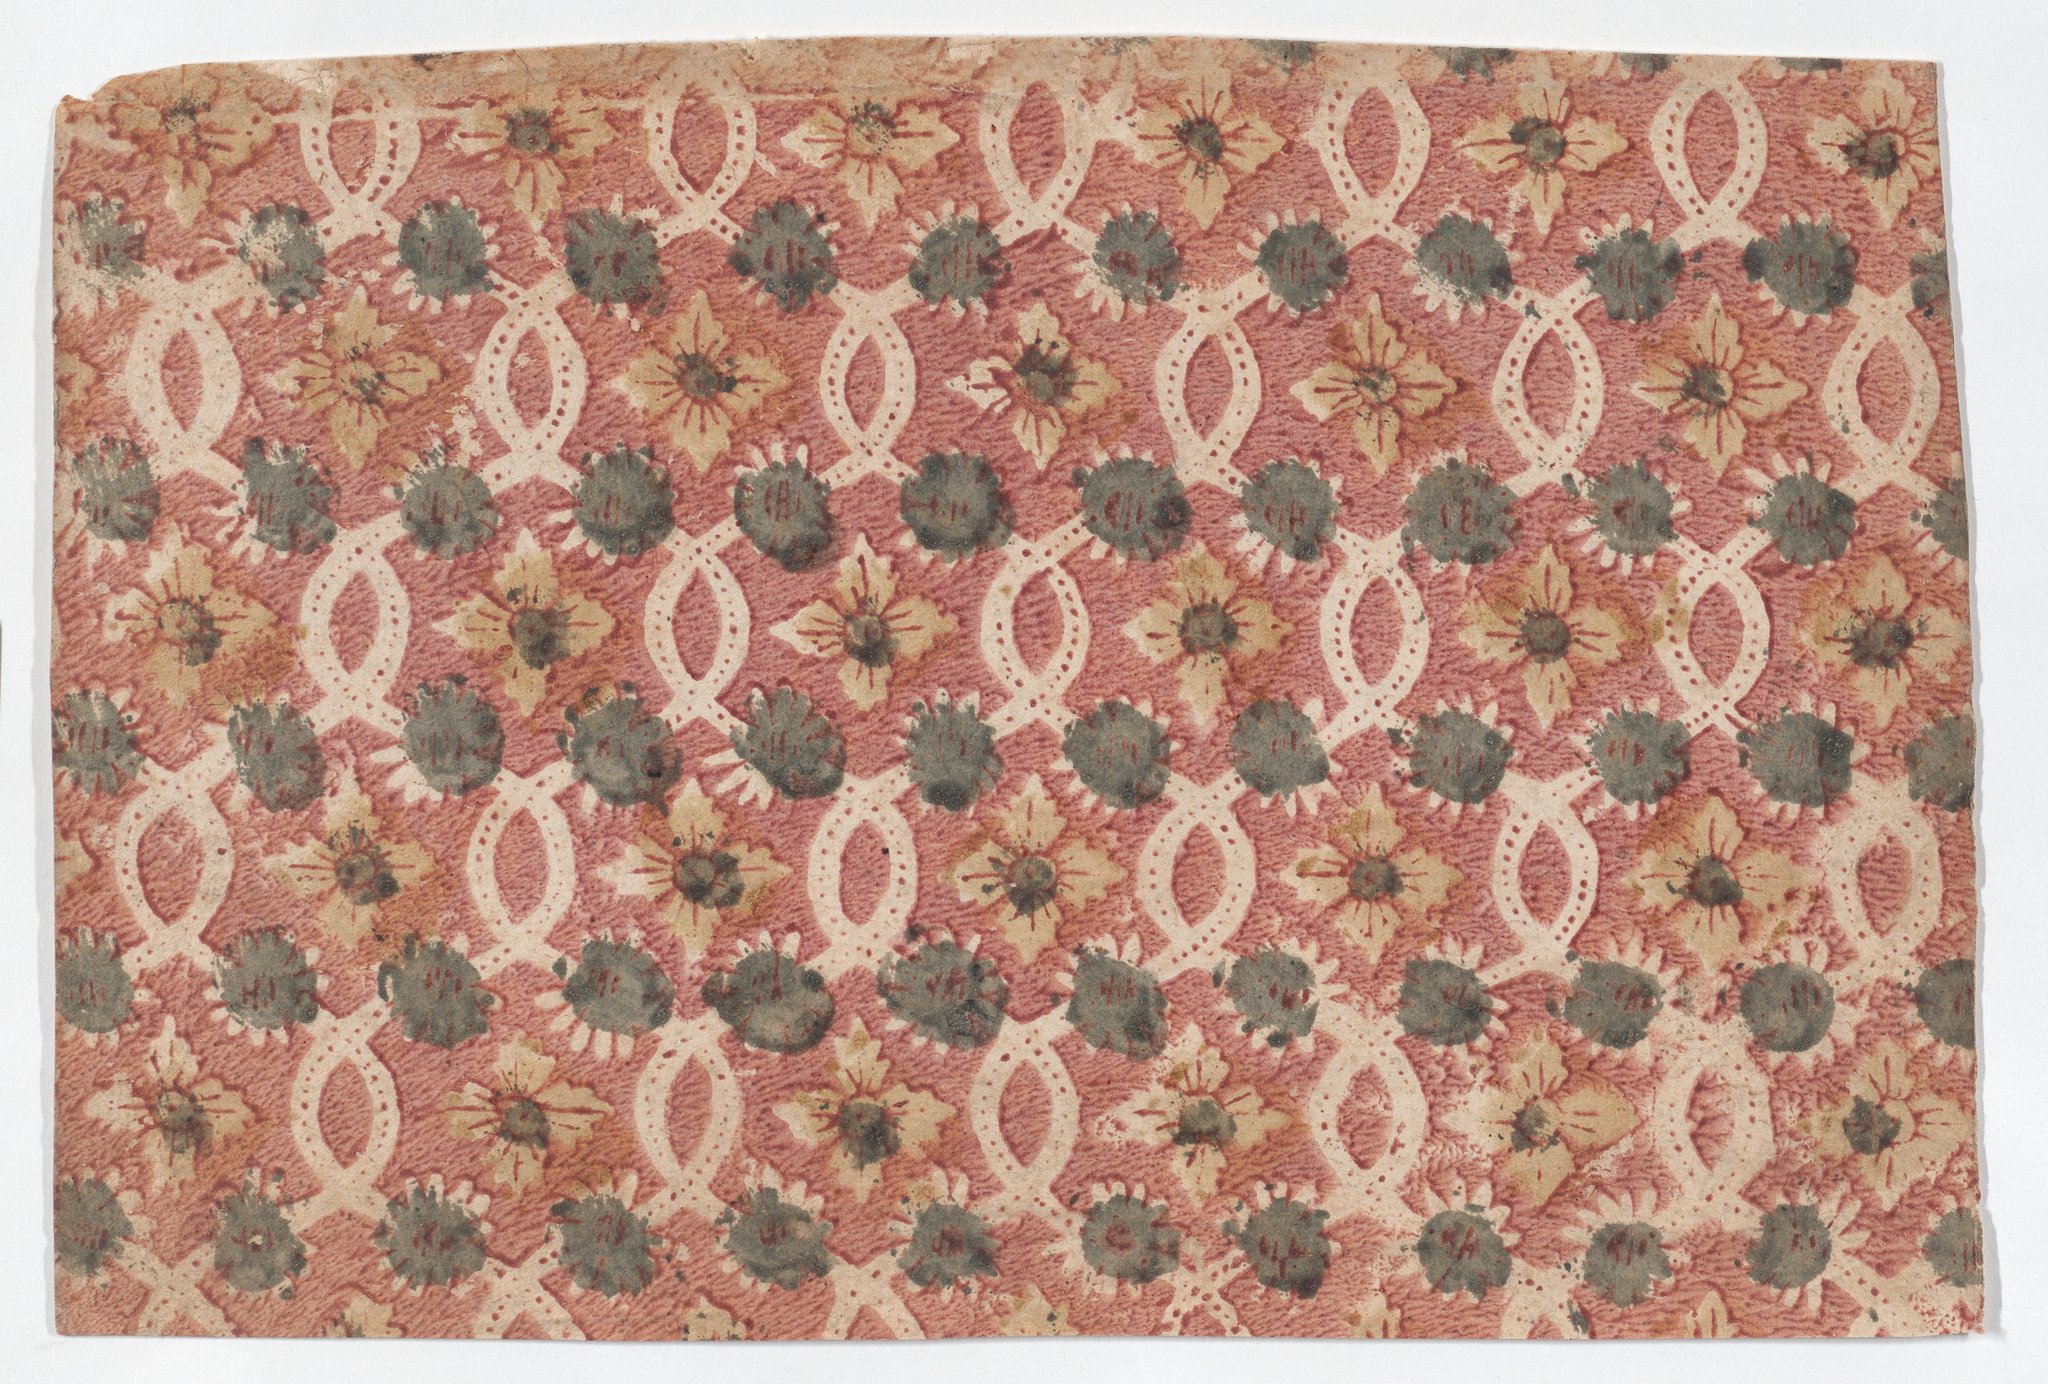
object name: print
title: Sheet with overall lattice pattern with rosettes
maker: Anonymous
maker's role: artist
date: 1801-1900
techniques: relief print